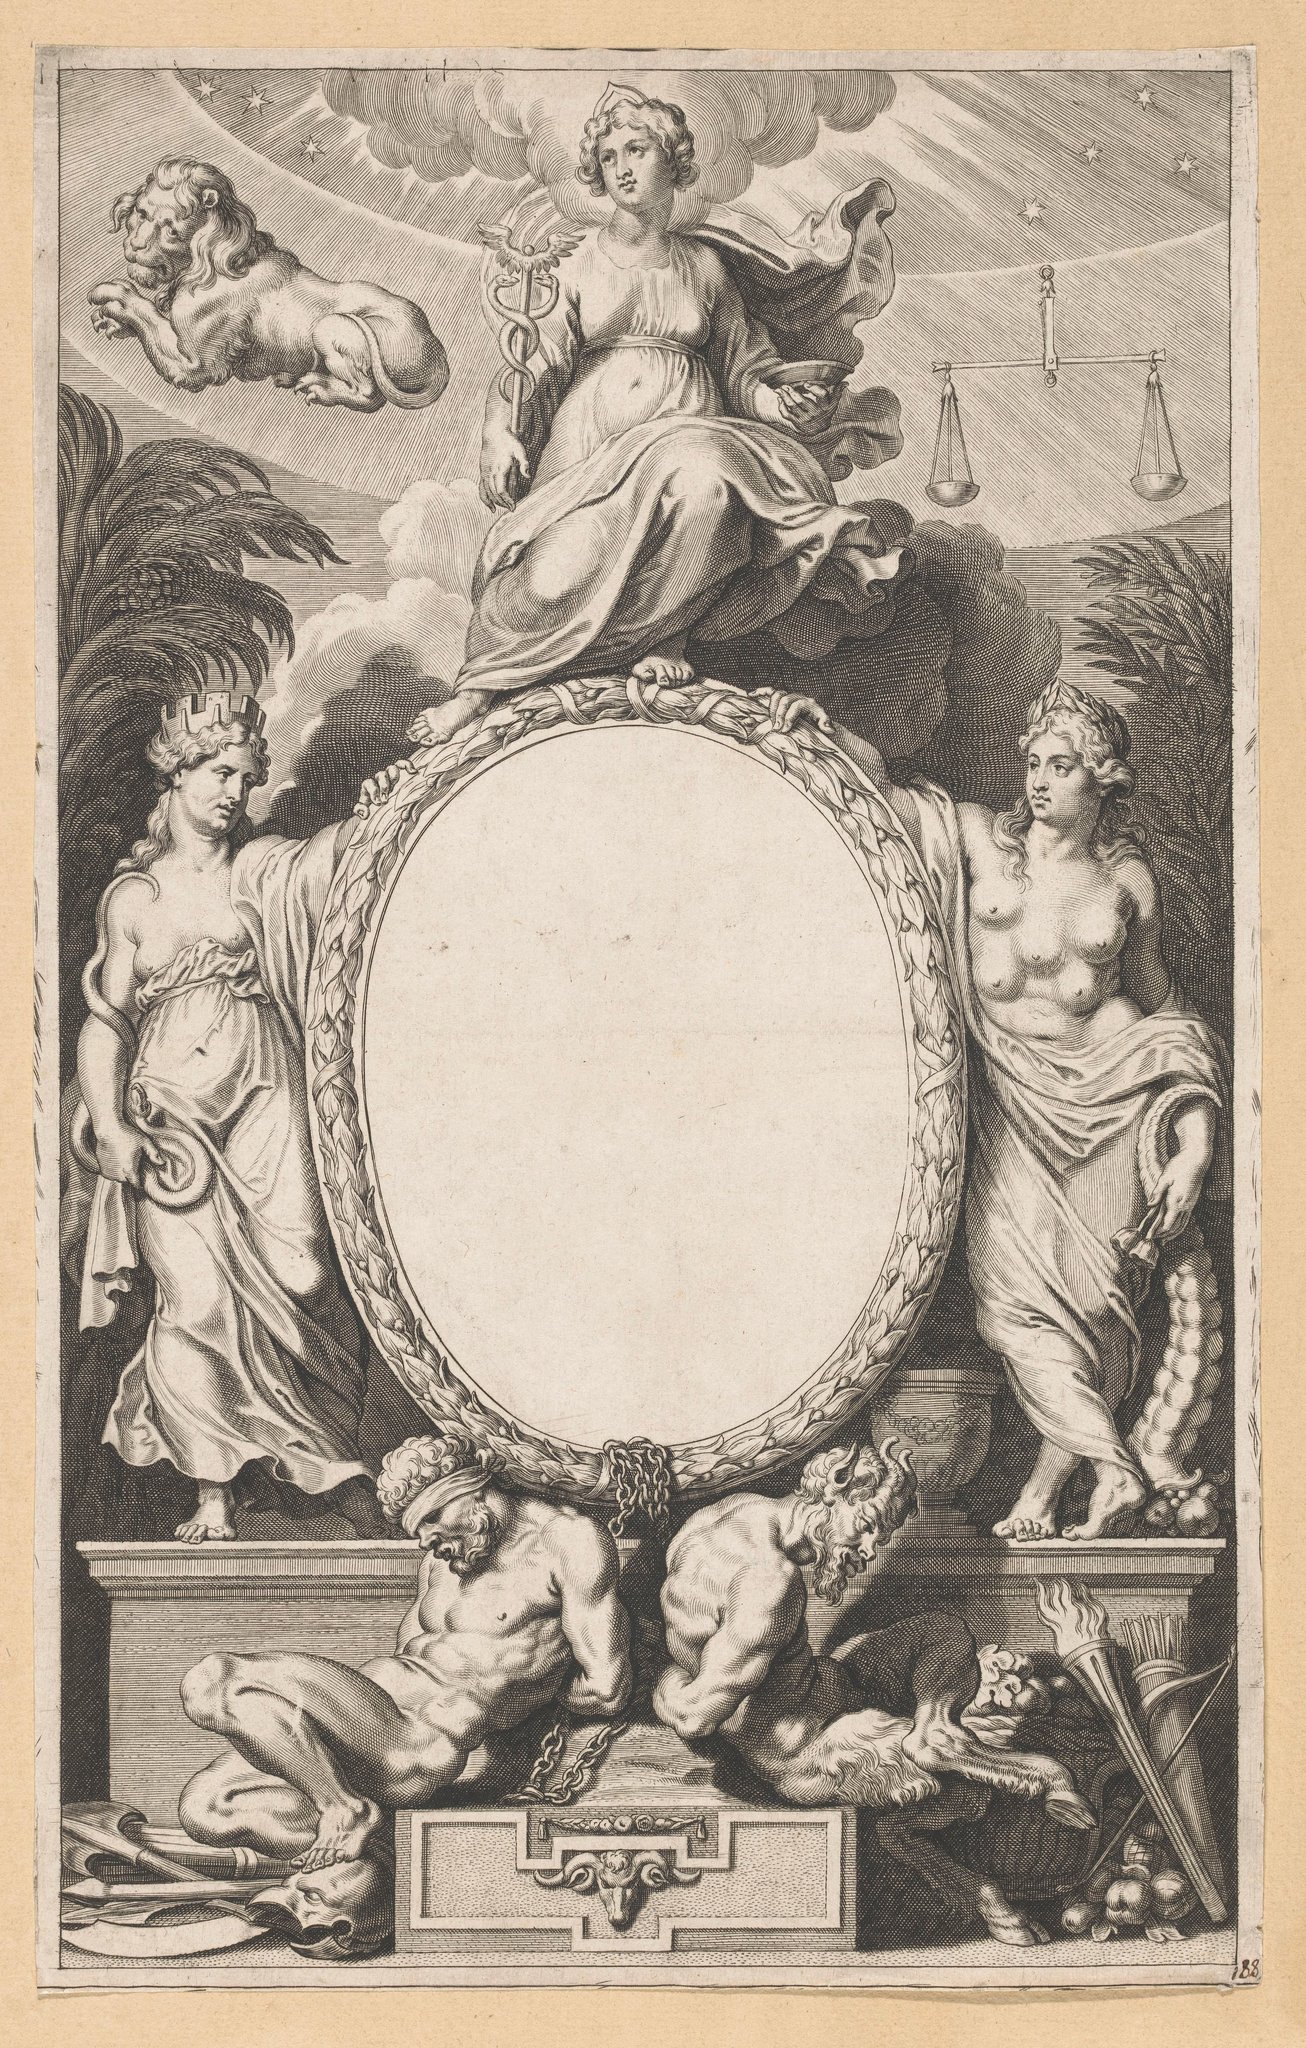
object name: titelblad, titelpagina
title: Allegorische titelpagina met tronende Astraea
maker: cornelis galle (i)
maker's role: print maker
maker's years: 1576-1650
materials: paper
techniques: engraving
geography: southern netherlands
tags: (story of) dike (astraea), goddess of righteousness and justice, allegory, personification of good government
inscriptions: collector's mark: Lugt 240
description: Tronende Astraea met caduceus en kommetje in haar handen. Aan weerszijden van haar de sterrenbeelden leeuw en weegschaal. Links de personificatie van goed bestuur, met stedenkroon en slang. Rechts een vrouw met vijf borsten en een hoorn des overvloeds. Aan en sokkel zijn een man en een duivel geketend. Proefdruk voor een titelpagina van een boek over deugden en ondeugden.